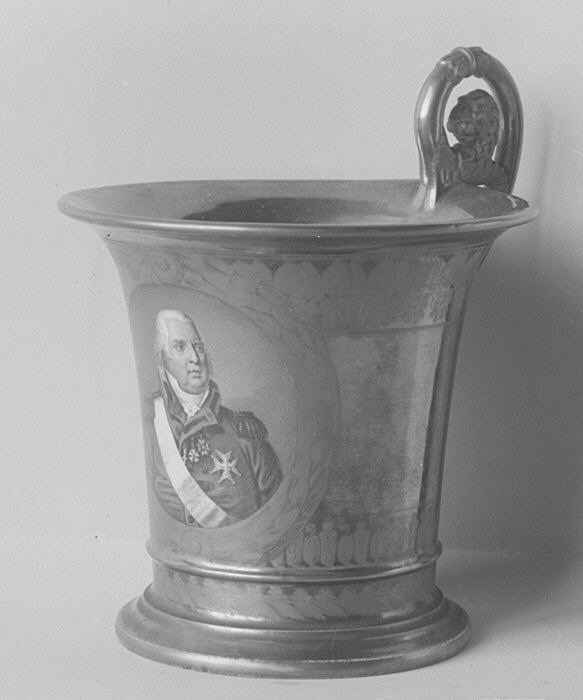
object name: cup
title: Cup (tasse Jasmin)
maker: jean-baptiste isabey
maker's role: artist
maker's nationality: french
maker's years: 1767-1855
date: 1815-1821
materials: hard paste porcelain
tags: men,portraits